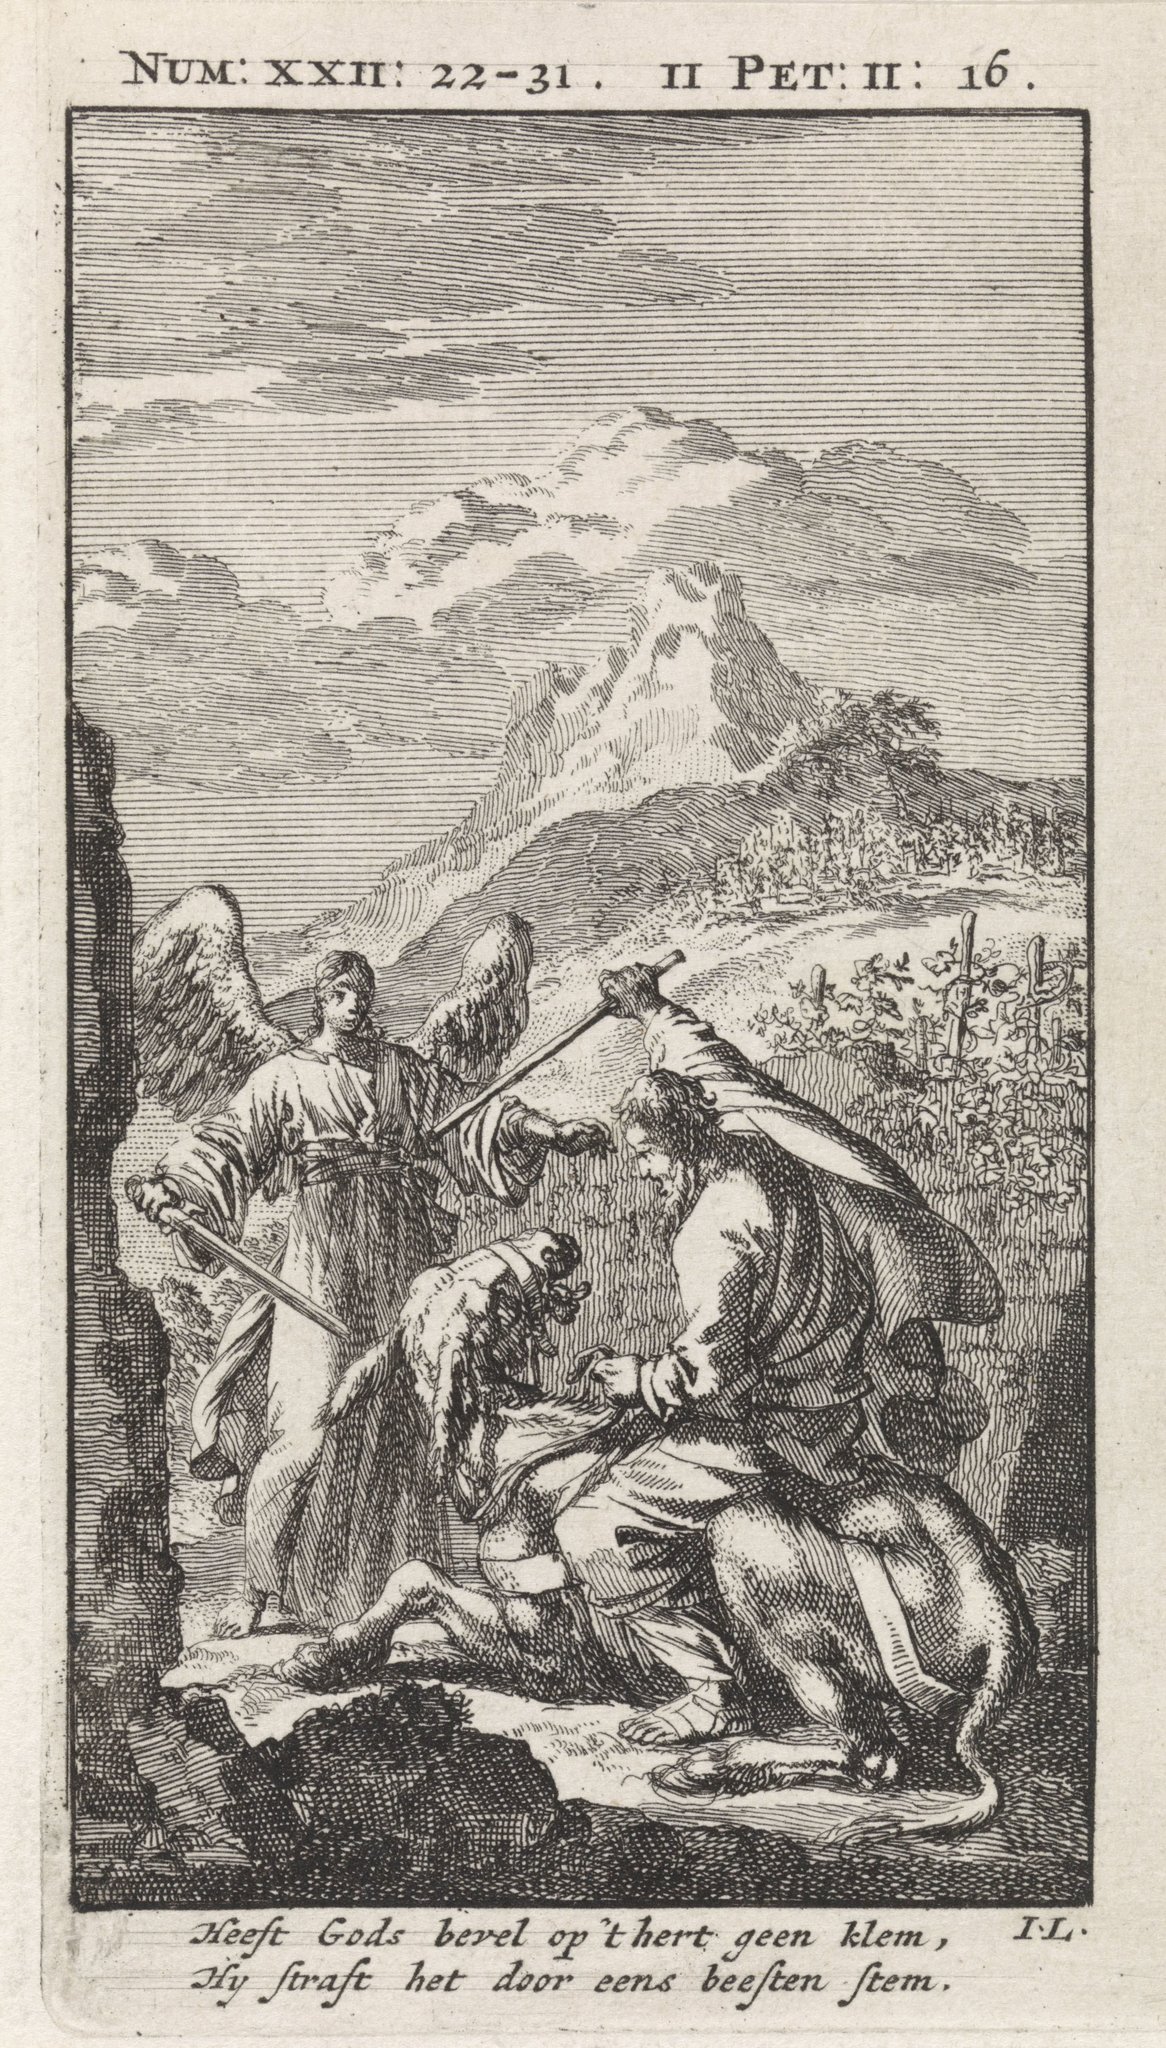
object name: book illustration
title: Bileam en zijn ezel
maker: jan luyken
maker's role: draughtsman, print maker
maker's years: 1649-1712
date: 1712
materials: paper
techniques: etching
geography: amsterdam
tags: an angel holding a sword bars the way and causes balaam's ass to turn aside; the angel is invisible to balaam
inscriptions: collector's mark: Lugt 2228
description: Illustratie voor: Luyken, Jan. Bybel printen. Amsterdam: Pieter Arentsz. II (wed.) en Cornelis van der Sys, 1712, p. 7.